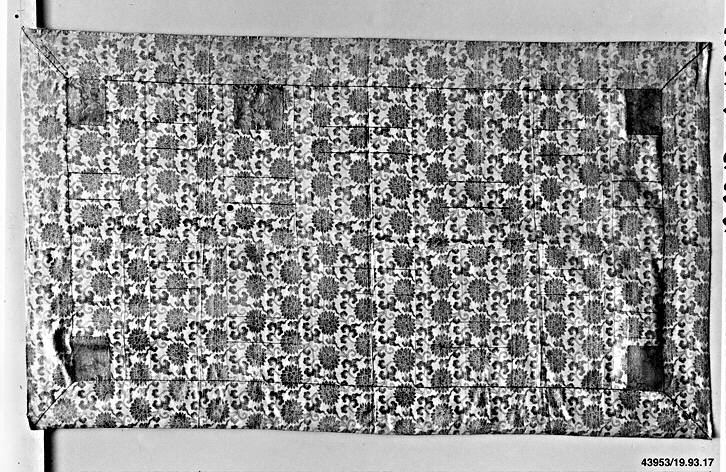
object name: robe, priest's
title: Seven-Panel Buddhist Monk’s Vestment (Shichijō kesa) with Double-Vined Peony Arabesque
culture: japanese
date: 1601-1700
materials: gold, silk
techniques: lampas, weave